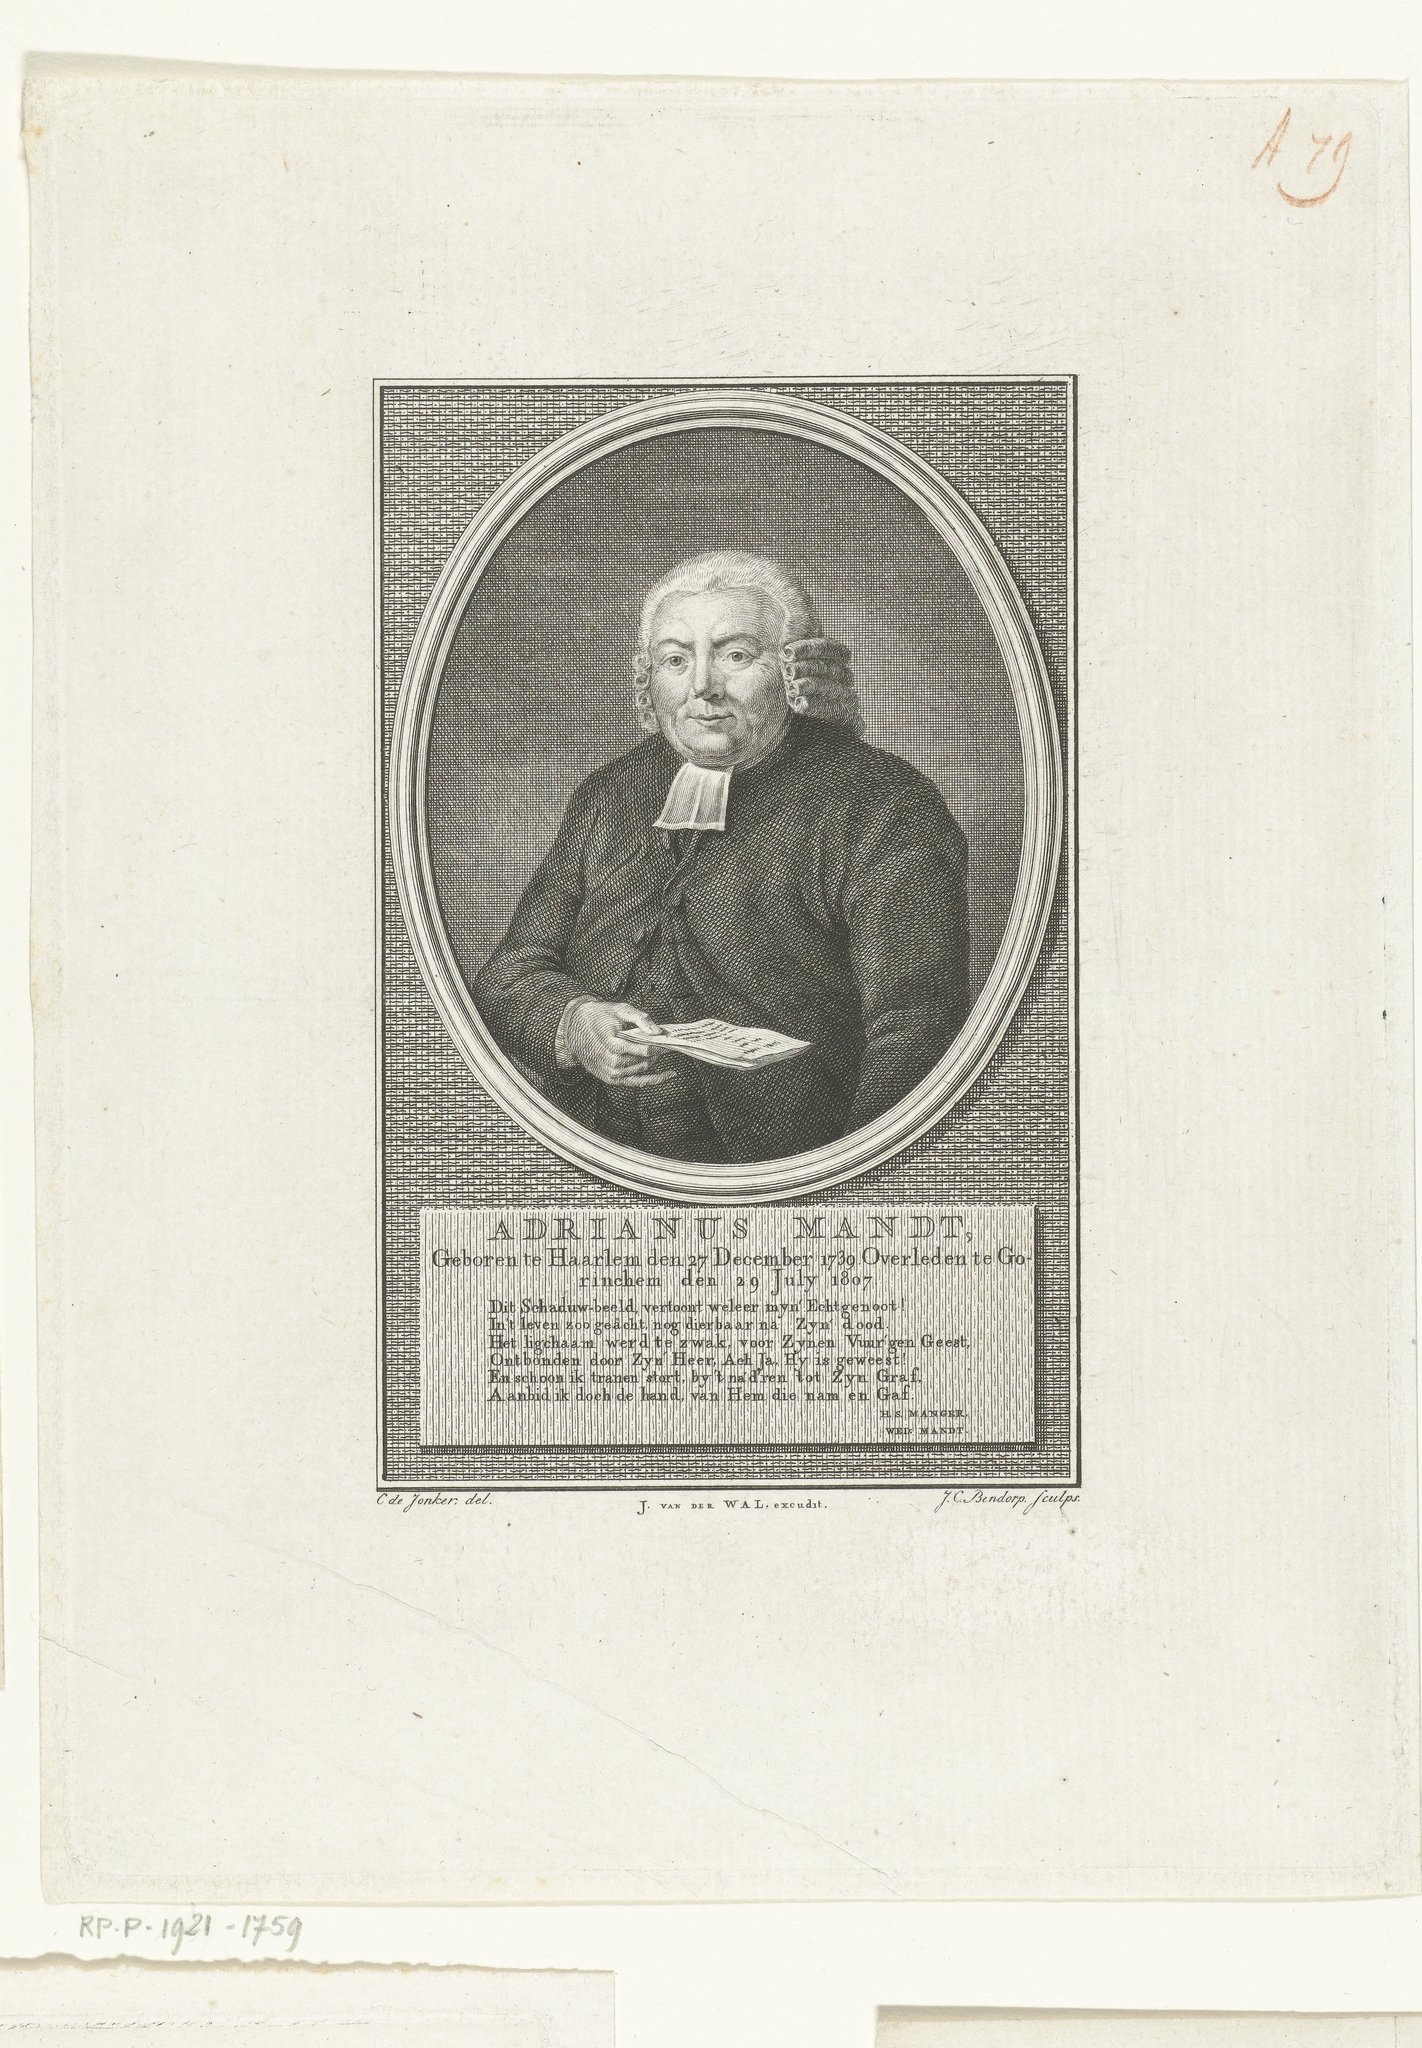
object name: print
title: Portret van predikant Adrianus Mandt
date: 1807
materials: paper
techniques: engraving, etching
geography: netherlands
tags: functionaries and dignitaries (with name) ~ episcopal protestant churches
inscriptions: collector's mark: Lugt 2228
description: Portret van predikant Adrianus Mandt in ovale omlijsting met lofdicht.